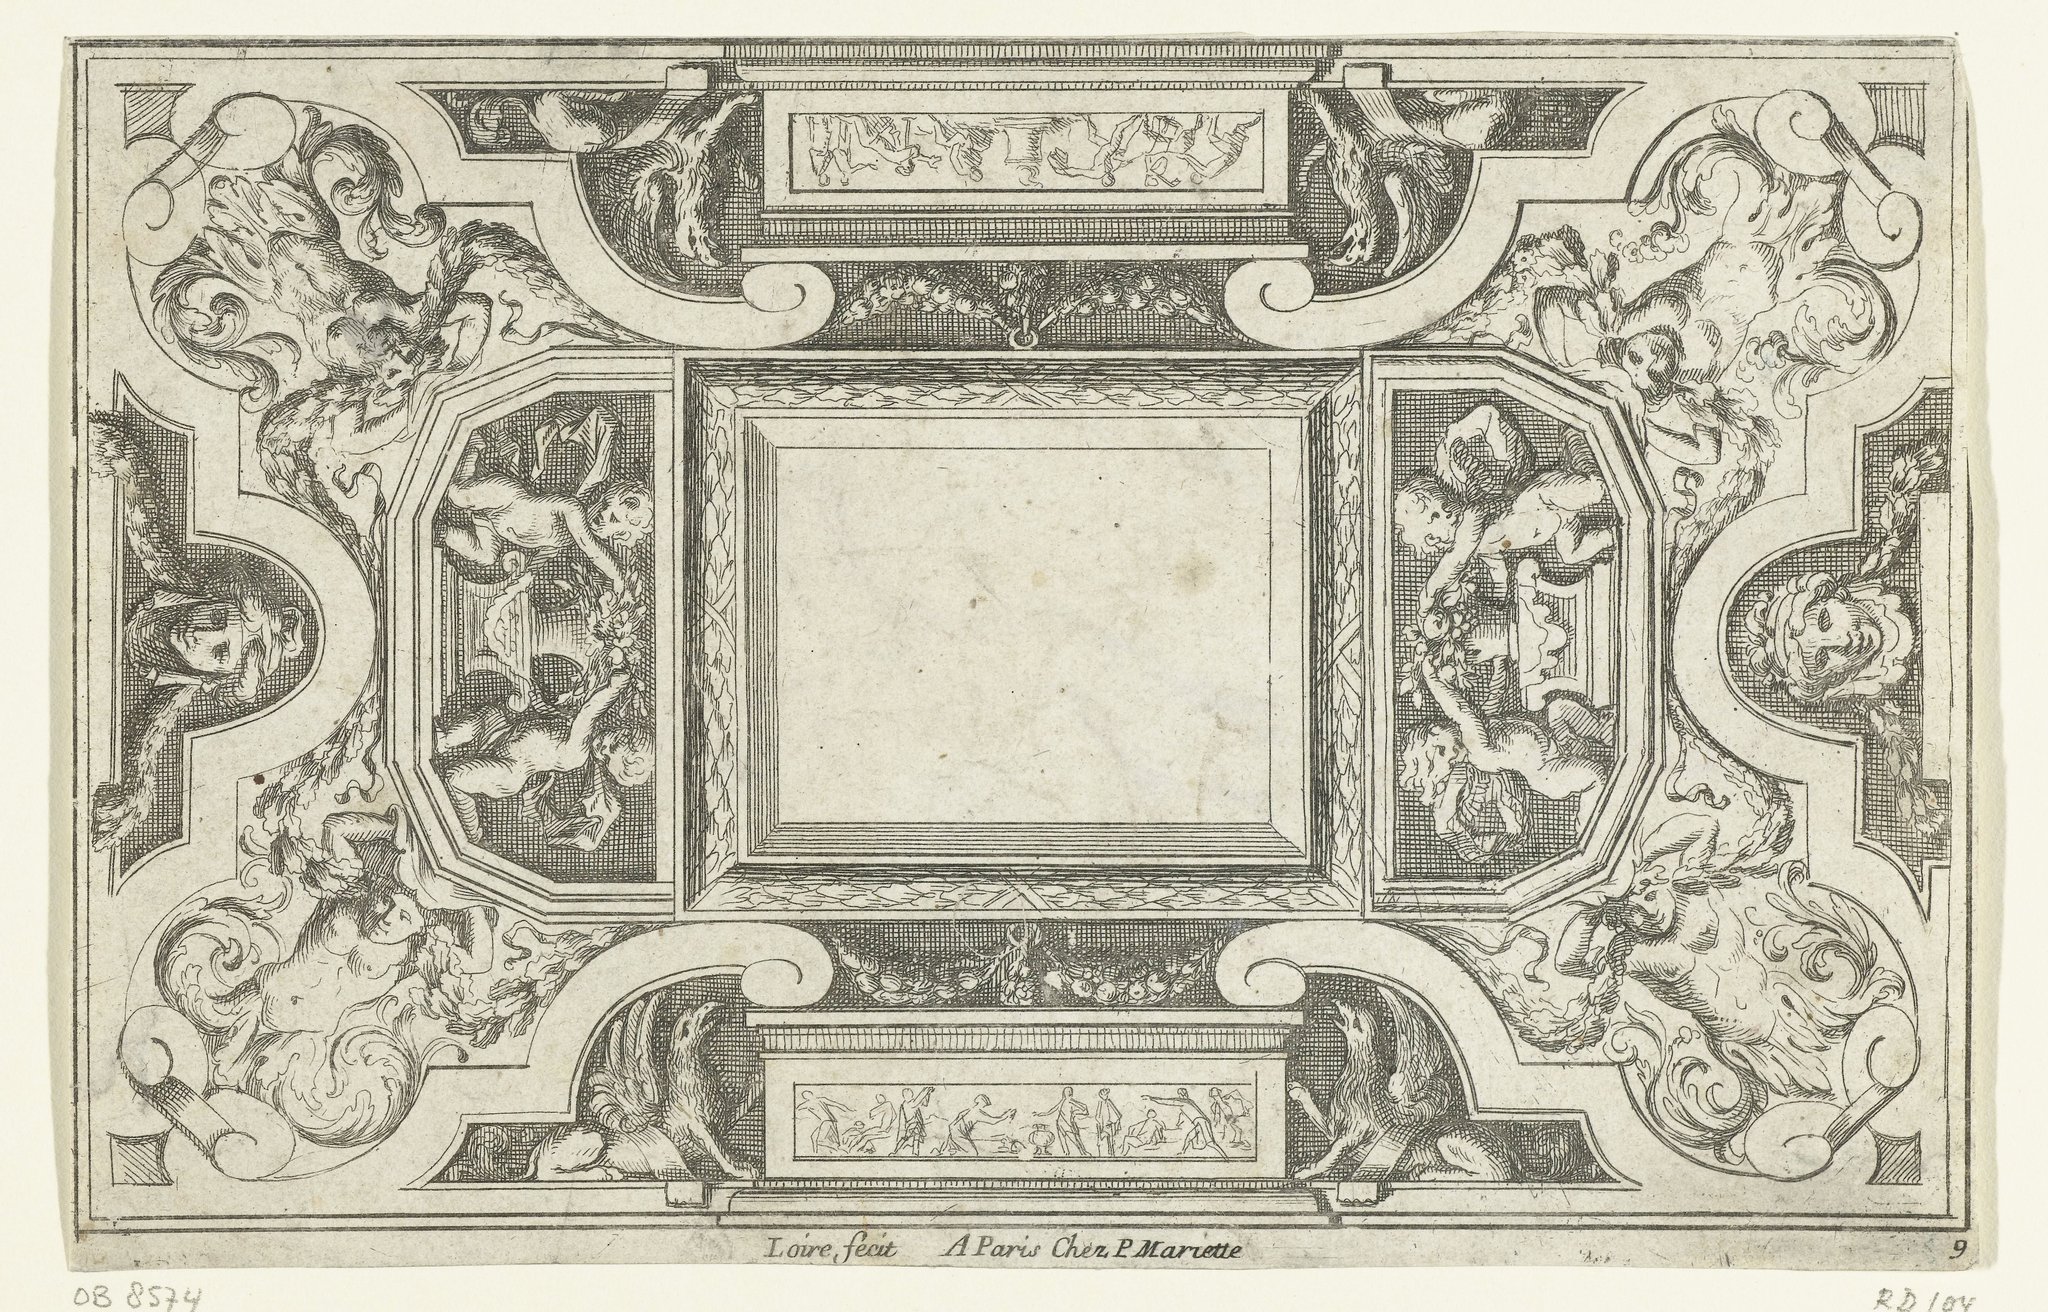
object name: print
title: Rechthoekig plafond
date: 1634-1716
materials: paper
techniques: etching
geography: france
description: In het midden een leeg vierkant vlak, de randen zijn verdeeld in panelen en in de hoeken ondersteunen bovenlichamen van hermen het middelste vlak. Uit tweede editie.